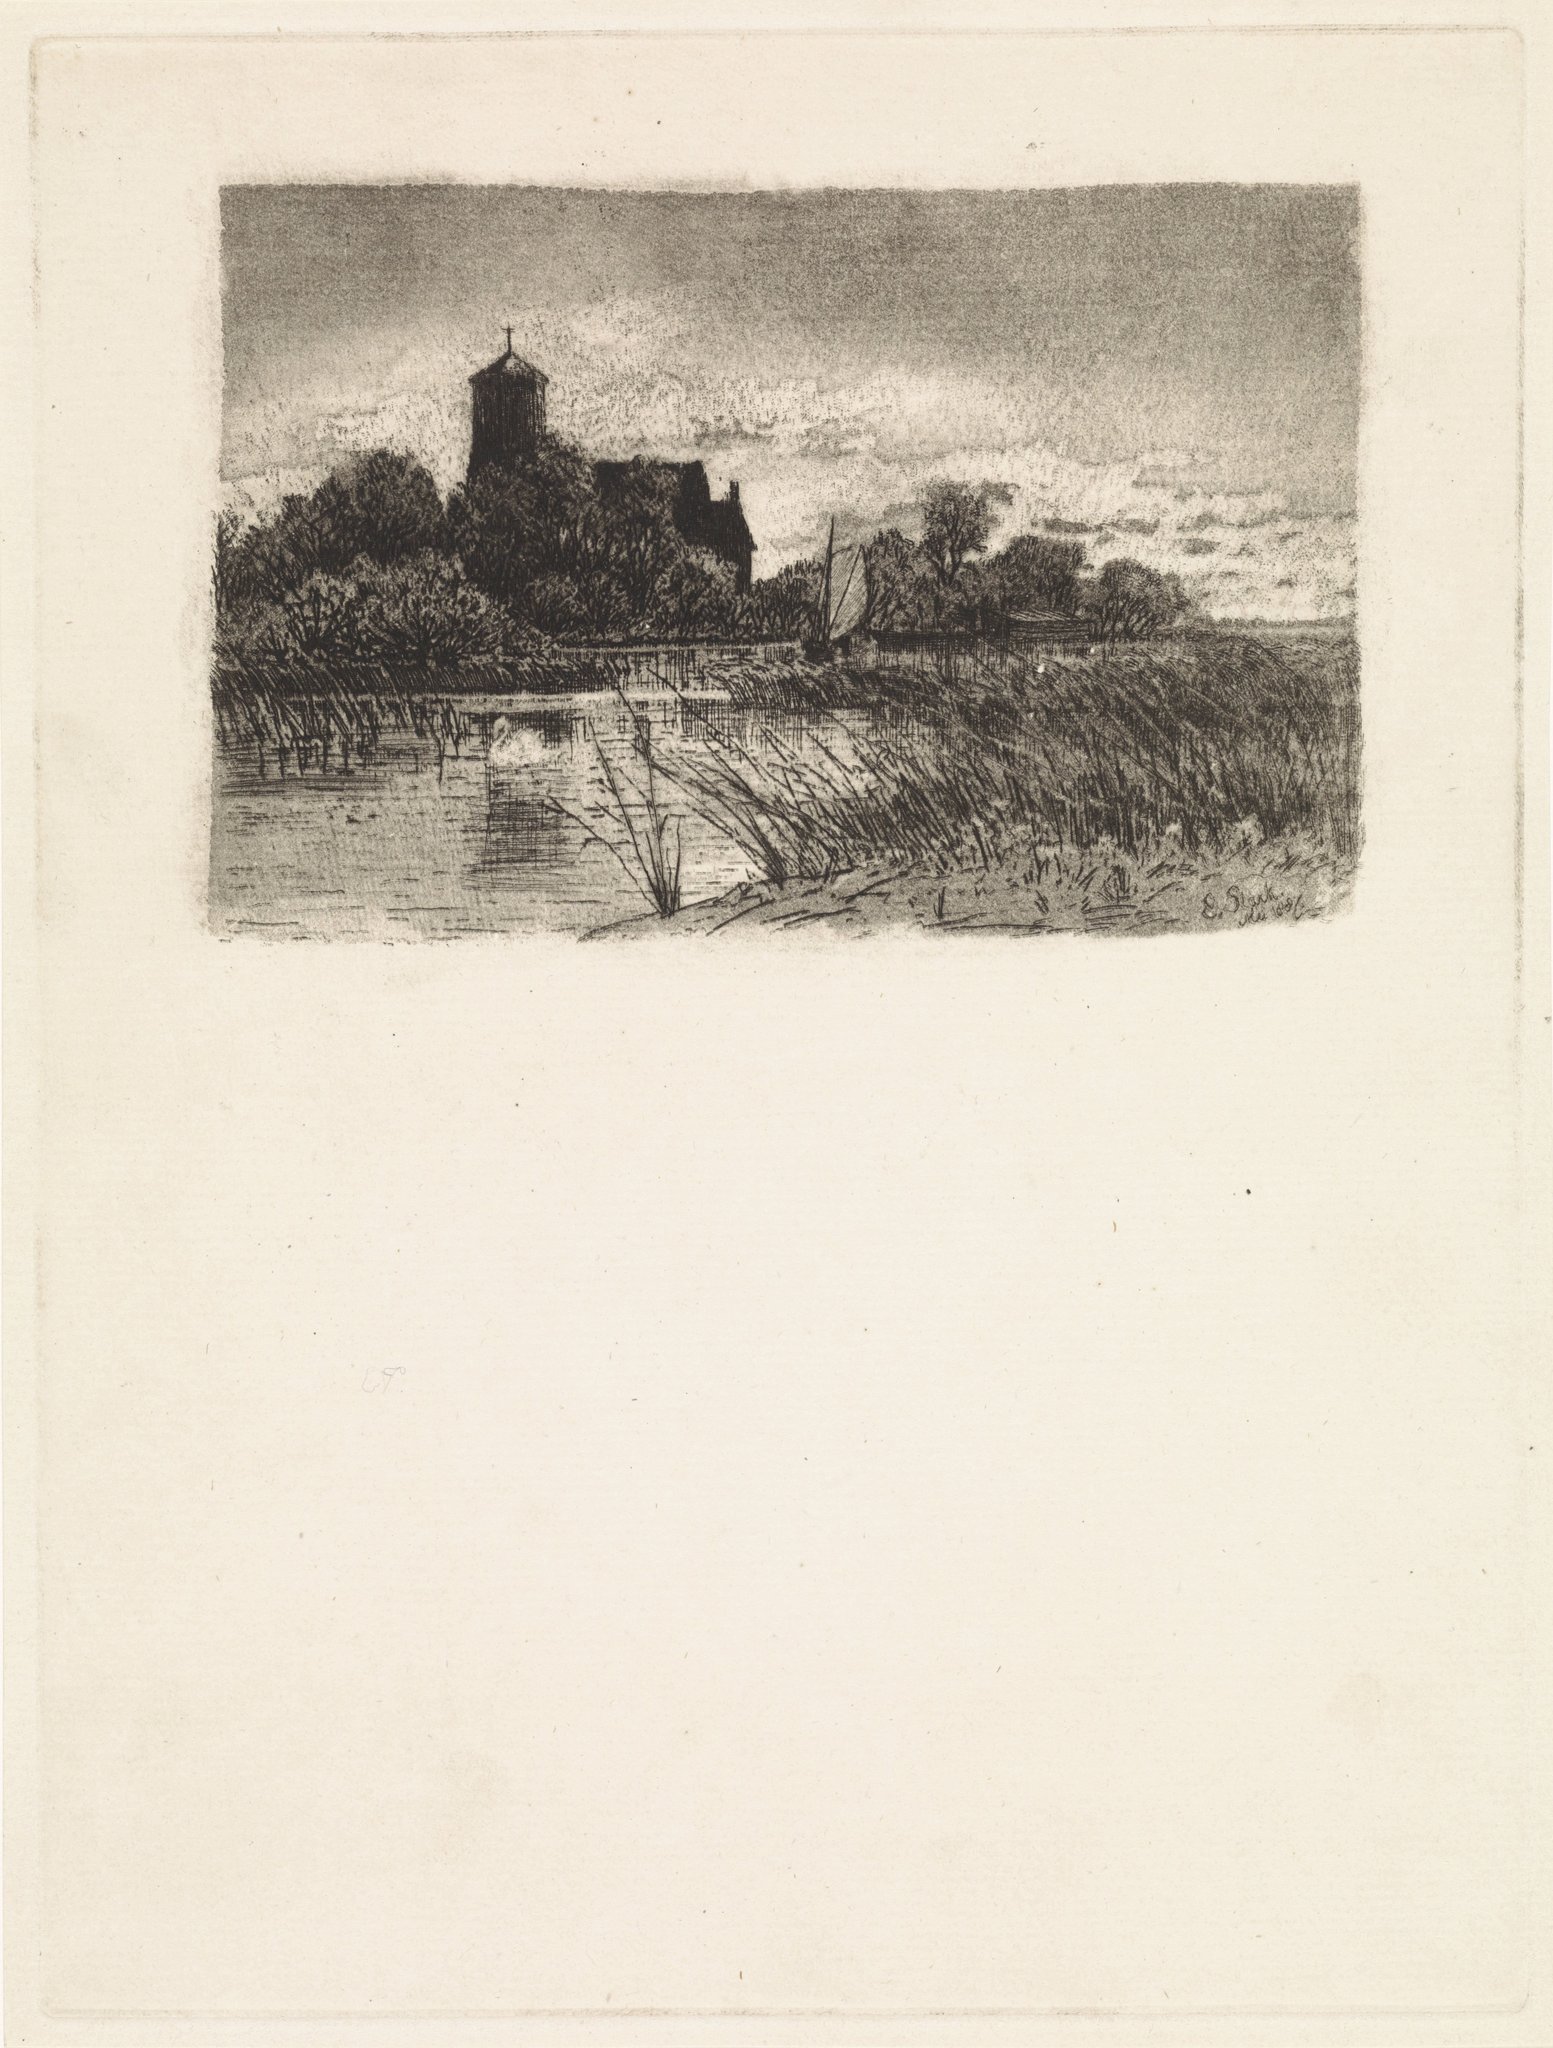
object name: print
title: Gezicht op de Sint Urbanuskerk te Bovenkerk met op het water een zeilscheepje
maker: elias stark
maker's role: draughtsman, print maker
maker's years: 1849-1933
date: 1805-1887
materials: paper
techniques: aquatint, etching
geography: nieuwer-amstel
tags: church (exterior)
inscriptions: collector's mark: Lugt 2228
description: Gezicht op de St. Urbanuskerk te Bovenkerk met op de voorgrond op het water een zeilscheepje en een zwaan.